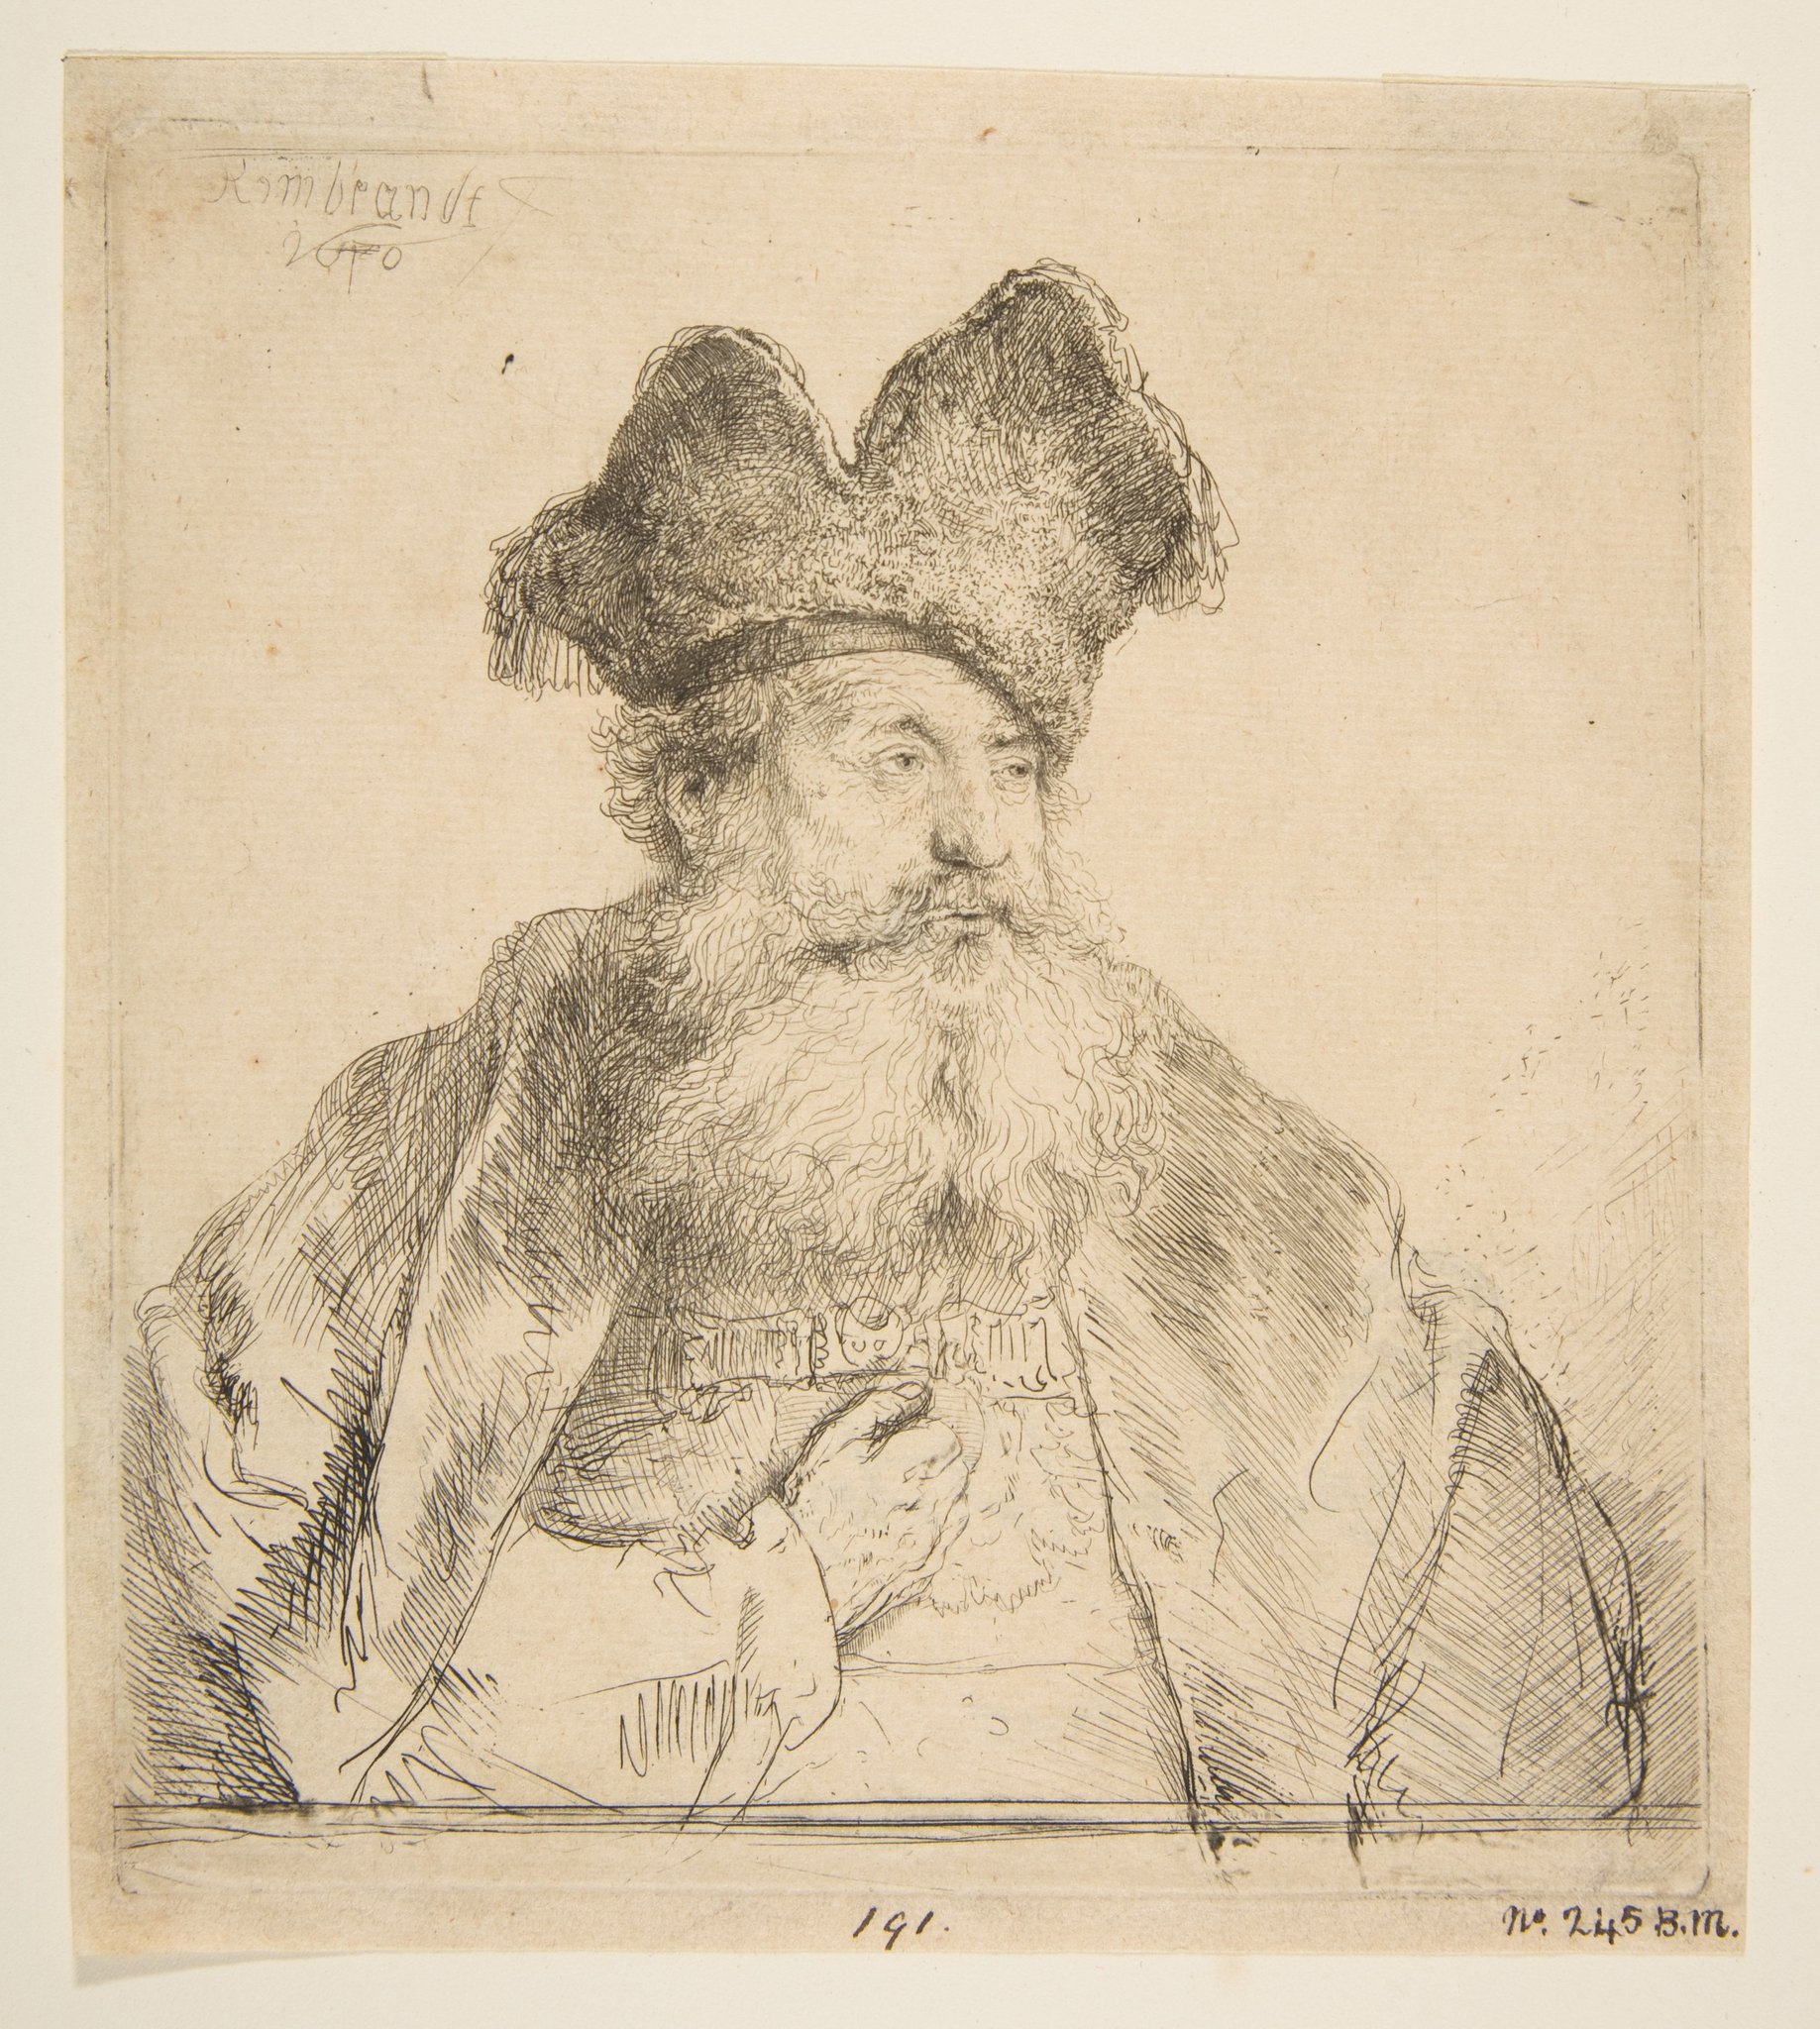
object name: print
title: Old Man with a Divided Fur Cap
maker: rembrandt van rijn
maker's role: artist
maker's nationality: dutch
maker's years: 1606-1669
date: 1640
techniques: drypoint, etching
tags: men,portraits